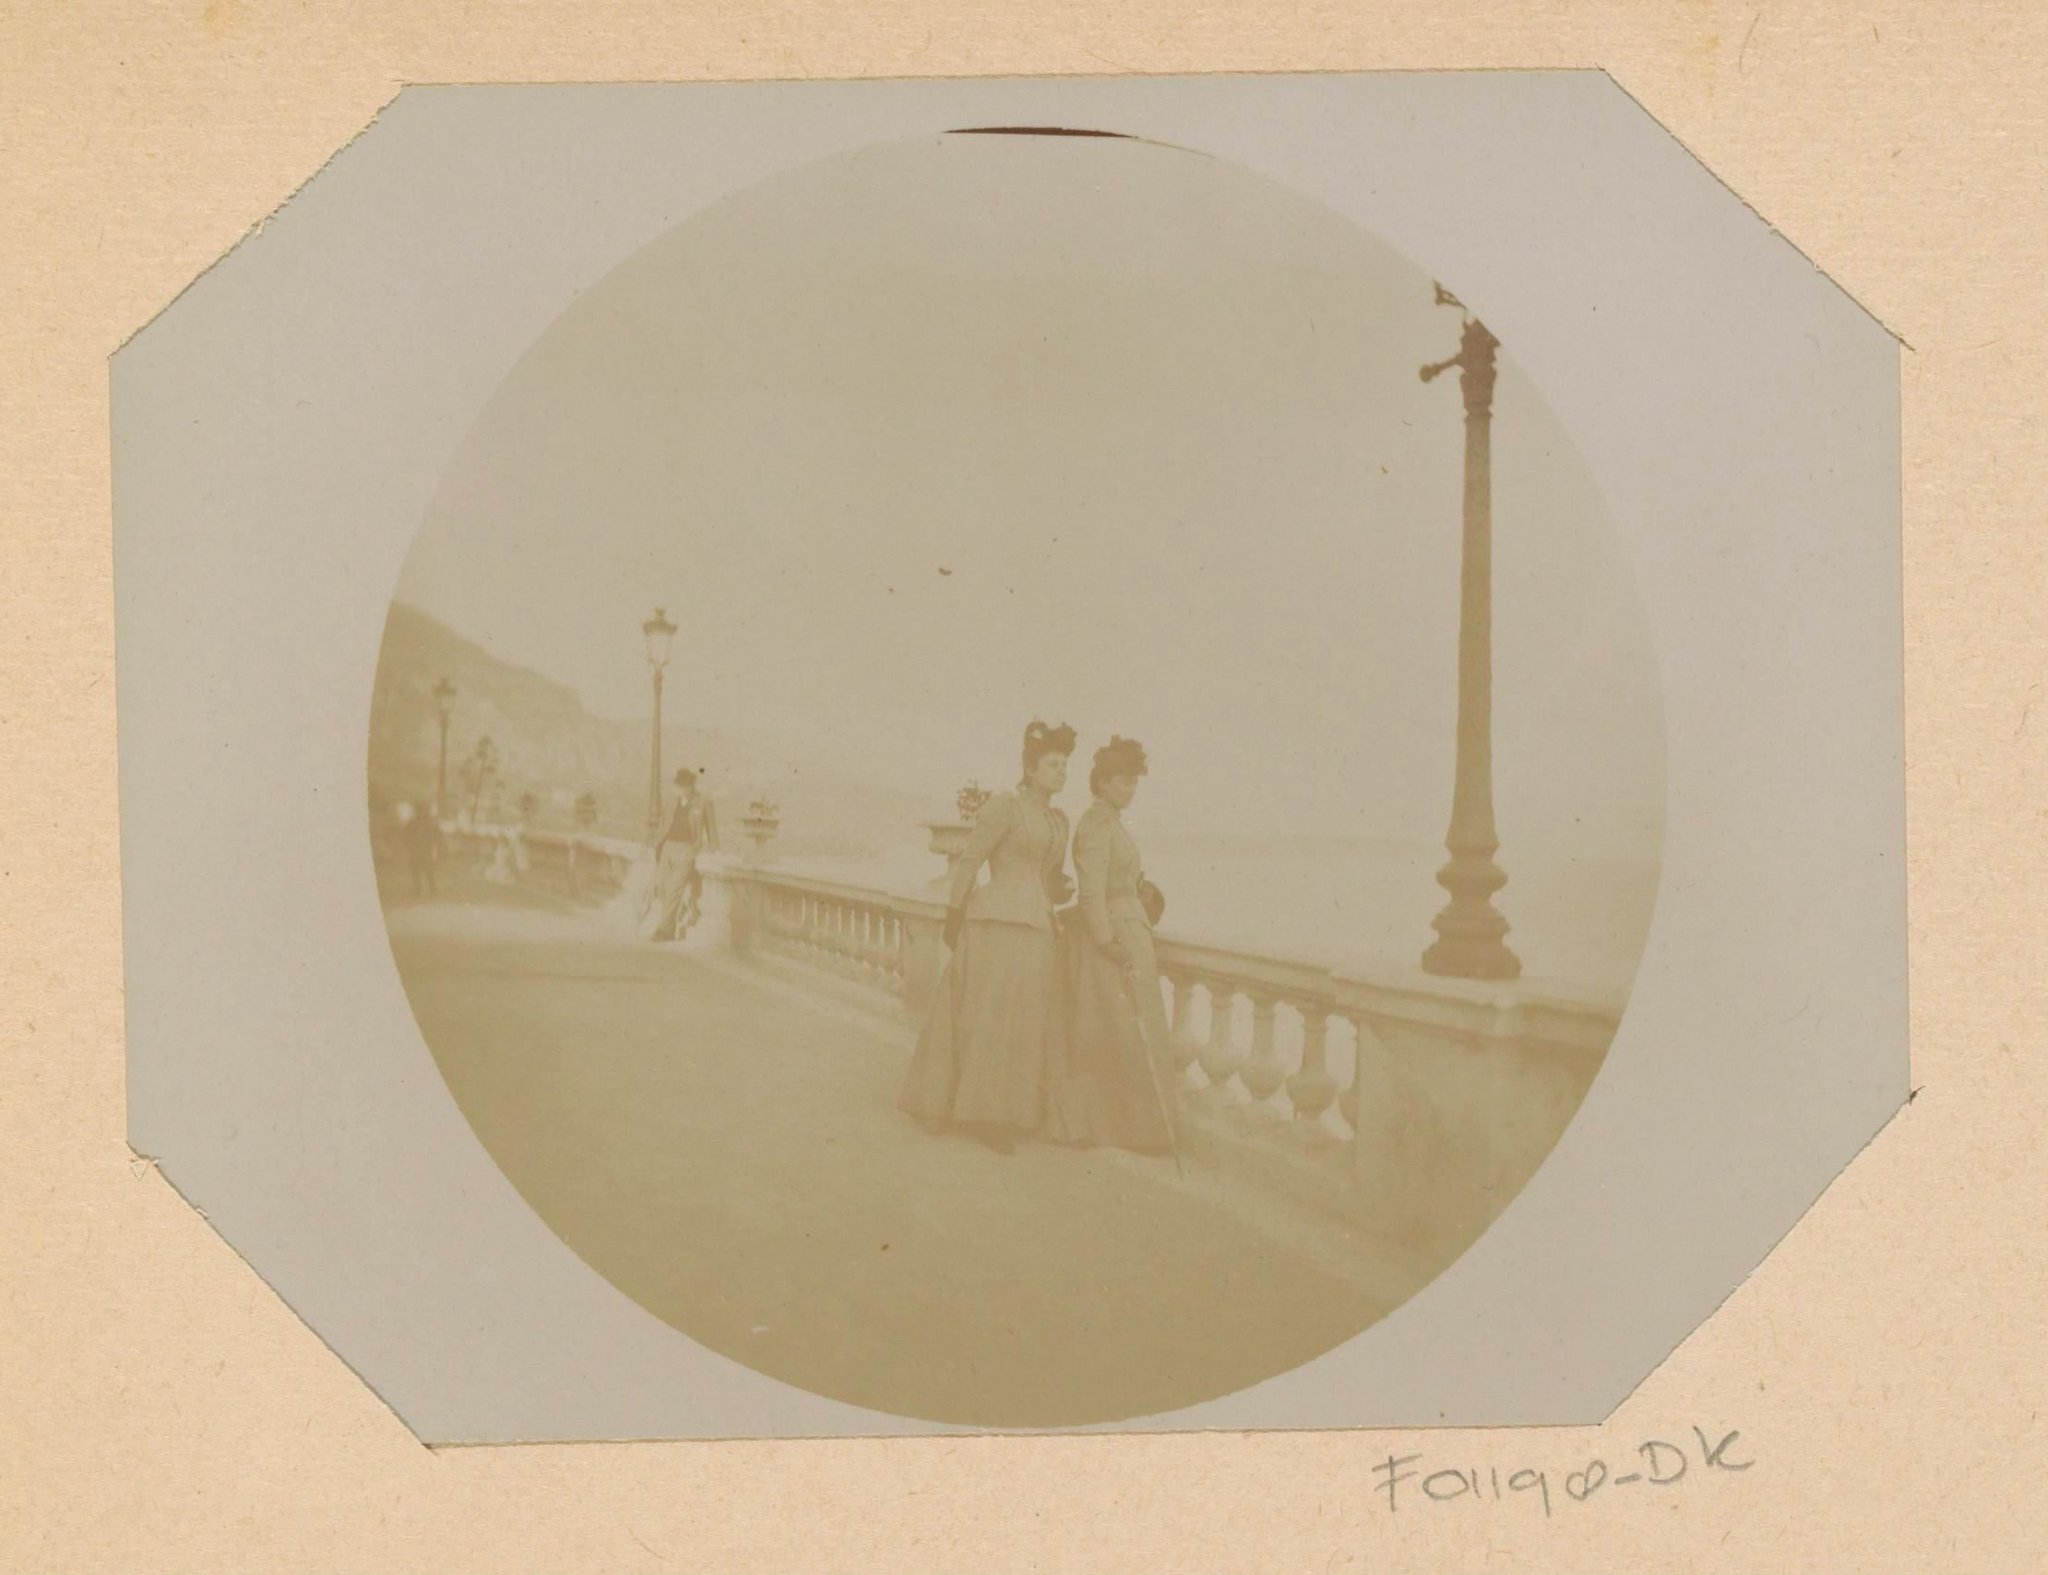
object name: album leaf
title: Monte-Carlo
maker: johanna margaretha piek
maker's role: fotograaf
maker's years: 1870-1947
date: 1889-1893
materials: paper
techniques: gelatin silver print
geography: monte carlo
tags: avenue, boulevard, promenade, esplanade